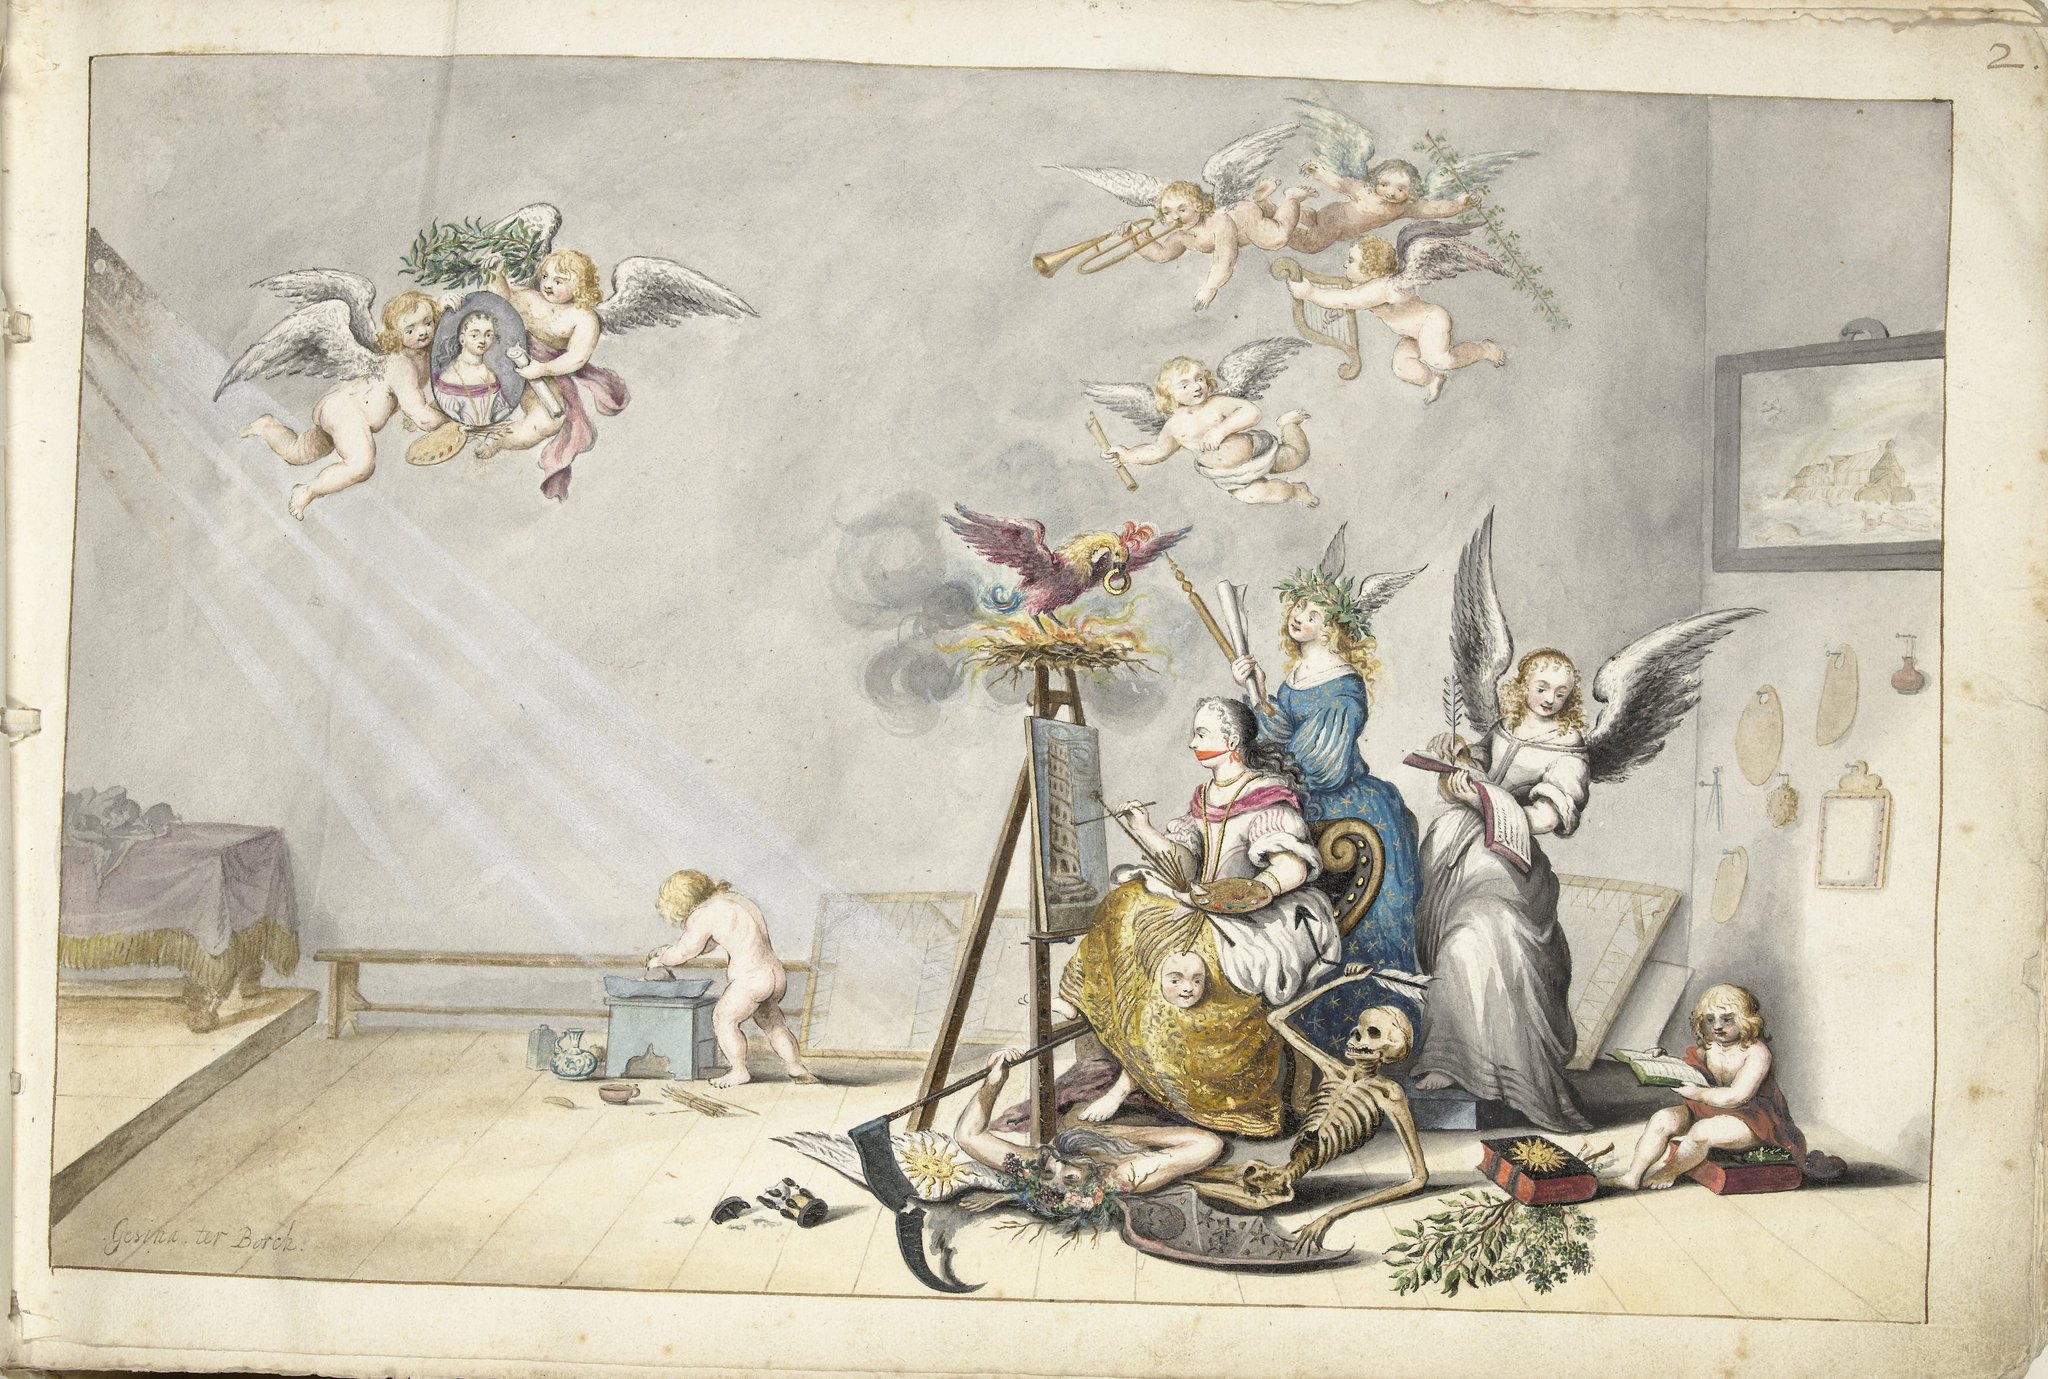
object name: drawing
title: De overwinning van de Schilderkunst over de Dood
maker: gesina ter borch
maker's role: draughtsman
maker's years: 1633-1690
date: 1660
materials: paint, ink, paper, watercolor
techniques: brush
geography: zwolle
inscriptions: signature: ‘Gesina ter Borch’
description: Tekening gemaakt naar de beschrijving van Gesina's vriend Henrik Jordis, die op de volgende pagina's in het album staat.